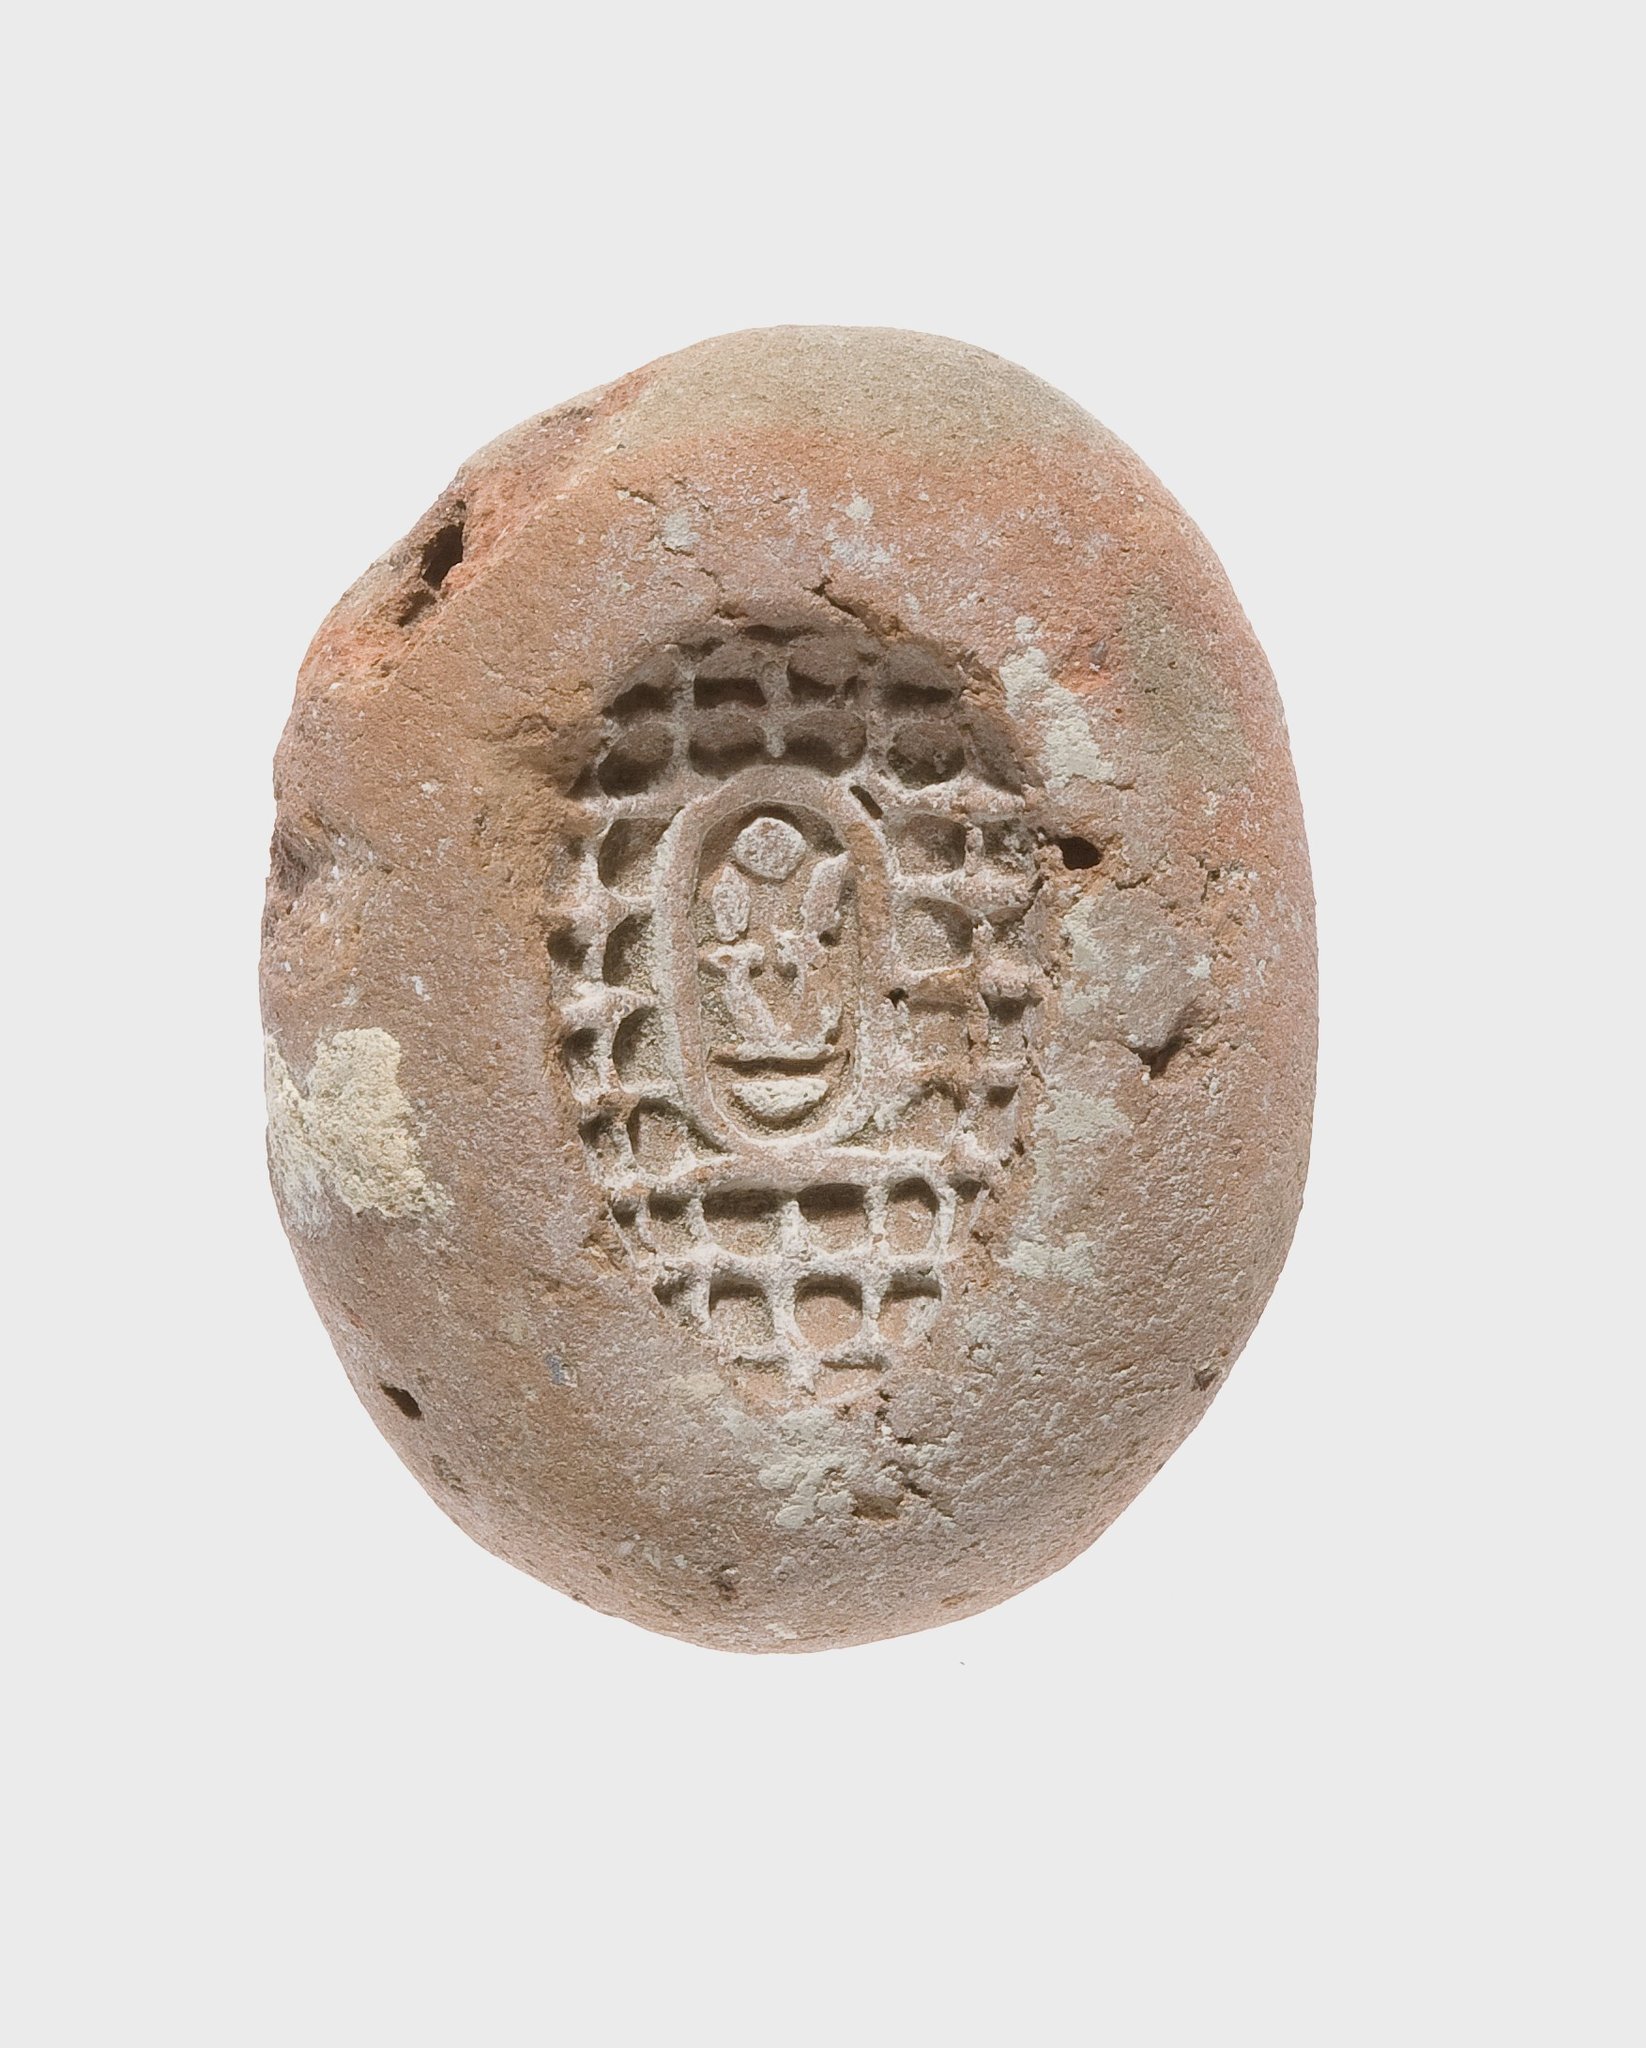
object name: mold, grape, cartouche, nebmaatre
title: Mold: Grapes with Cartouche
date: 1390-1352 BCE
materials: pottery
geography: egypt